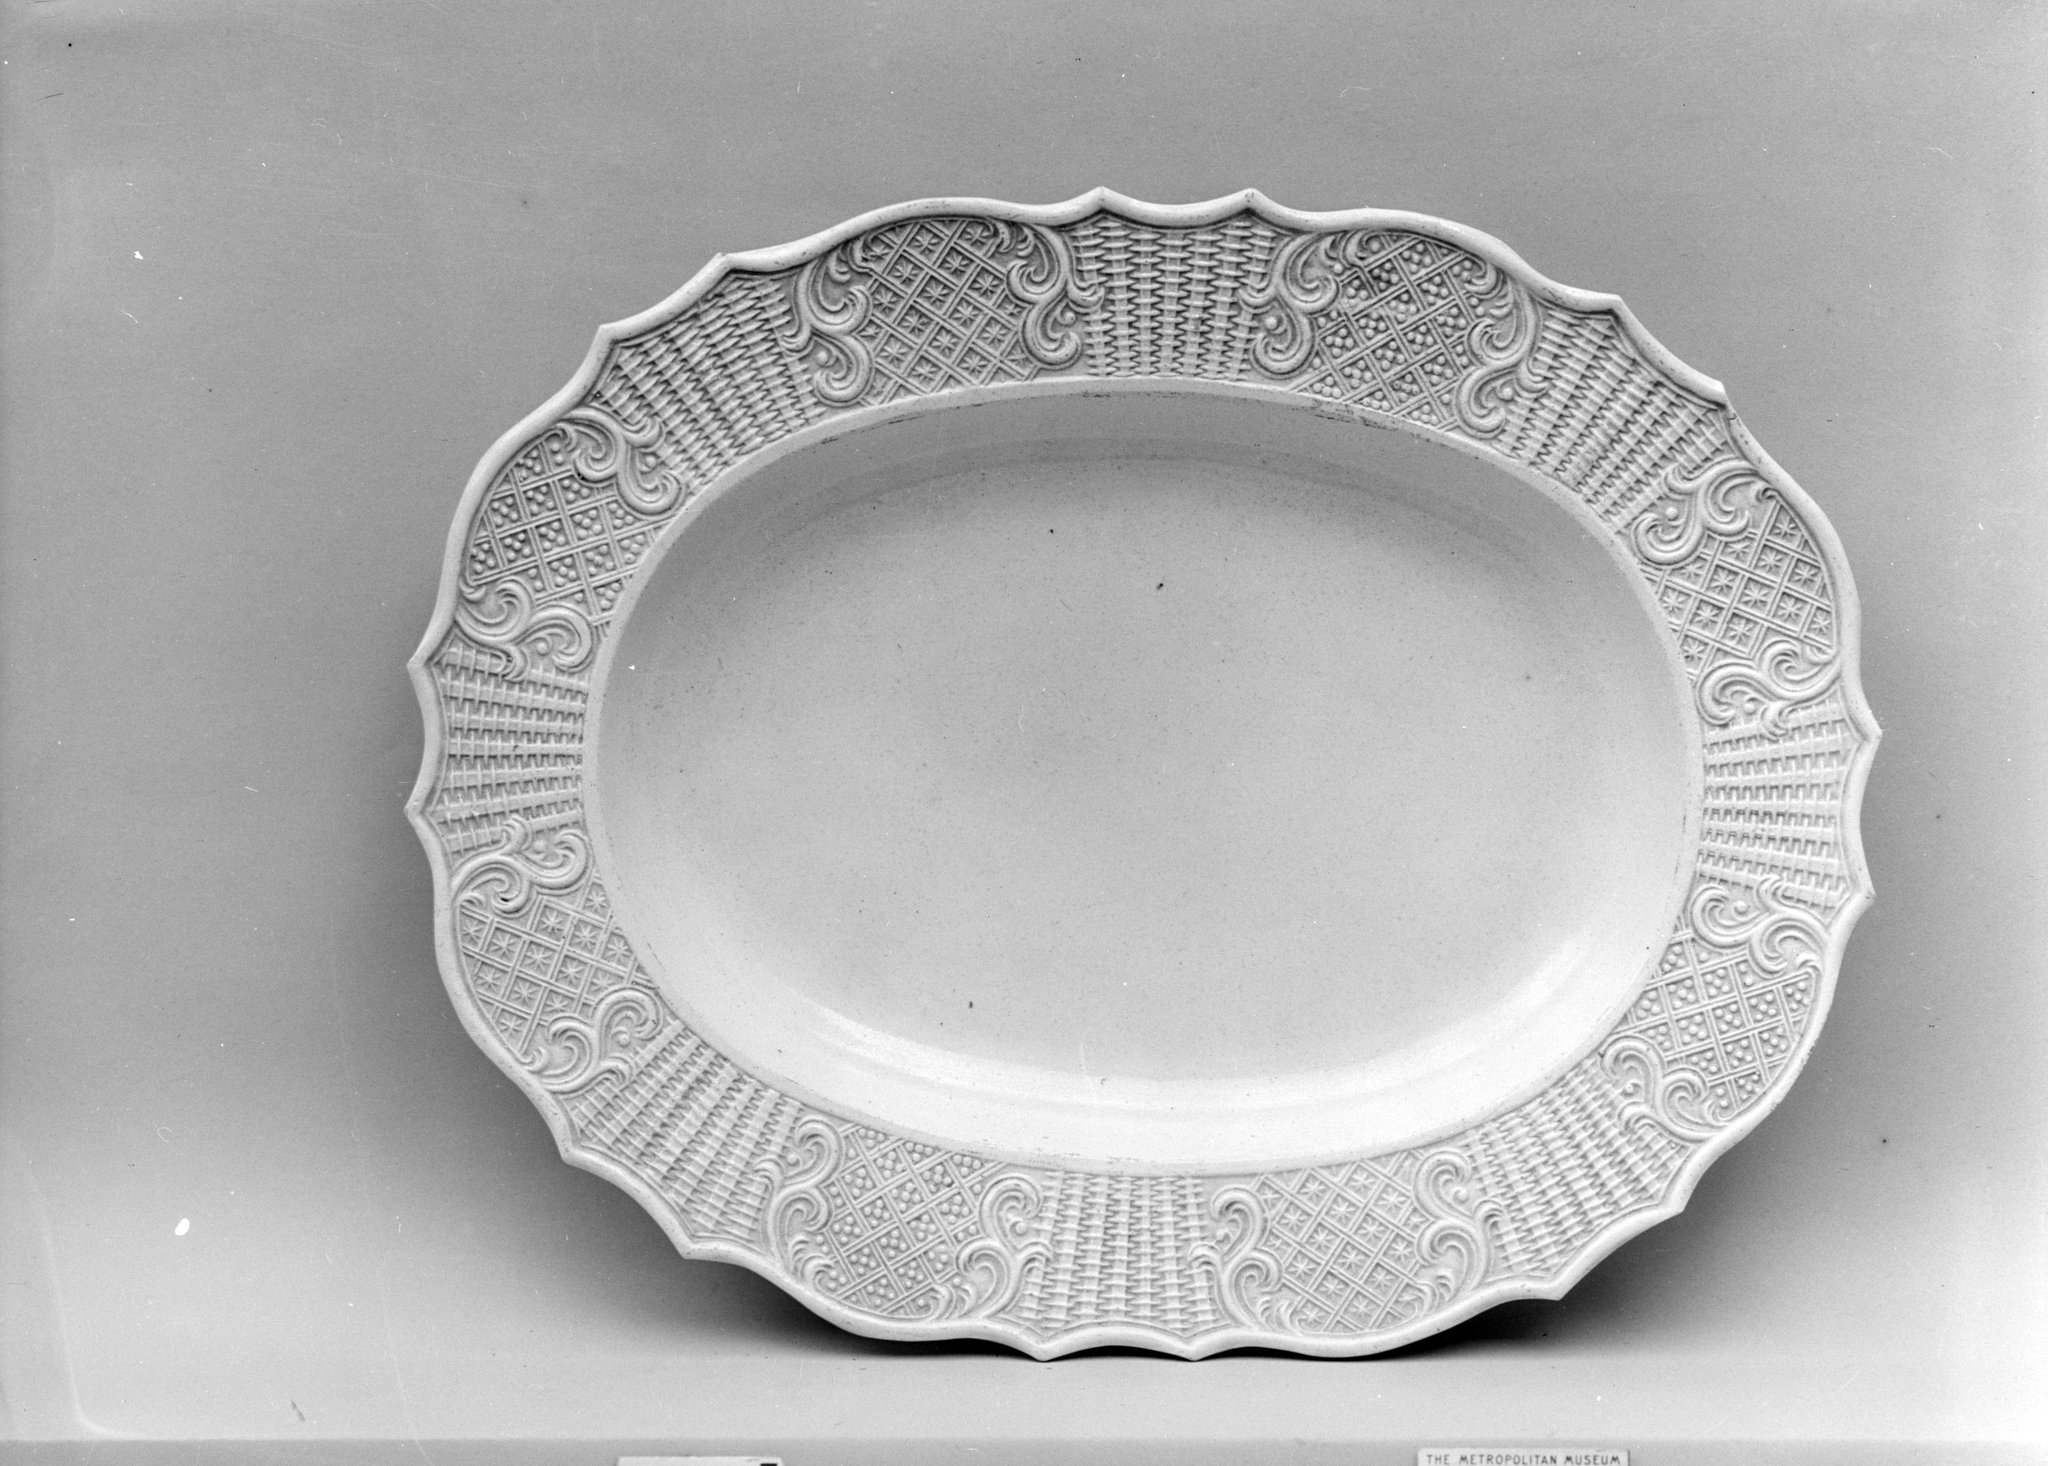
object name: platter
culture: british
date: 1750-1770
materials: stoneware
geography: england